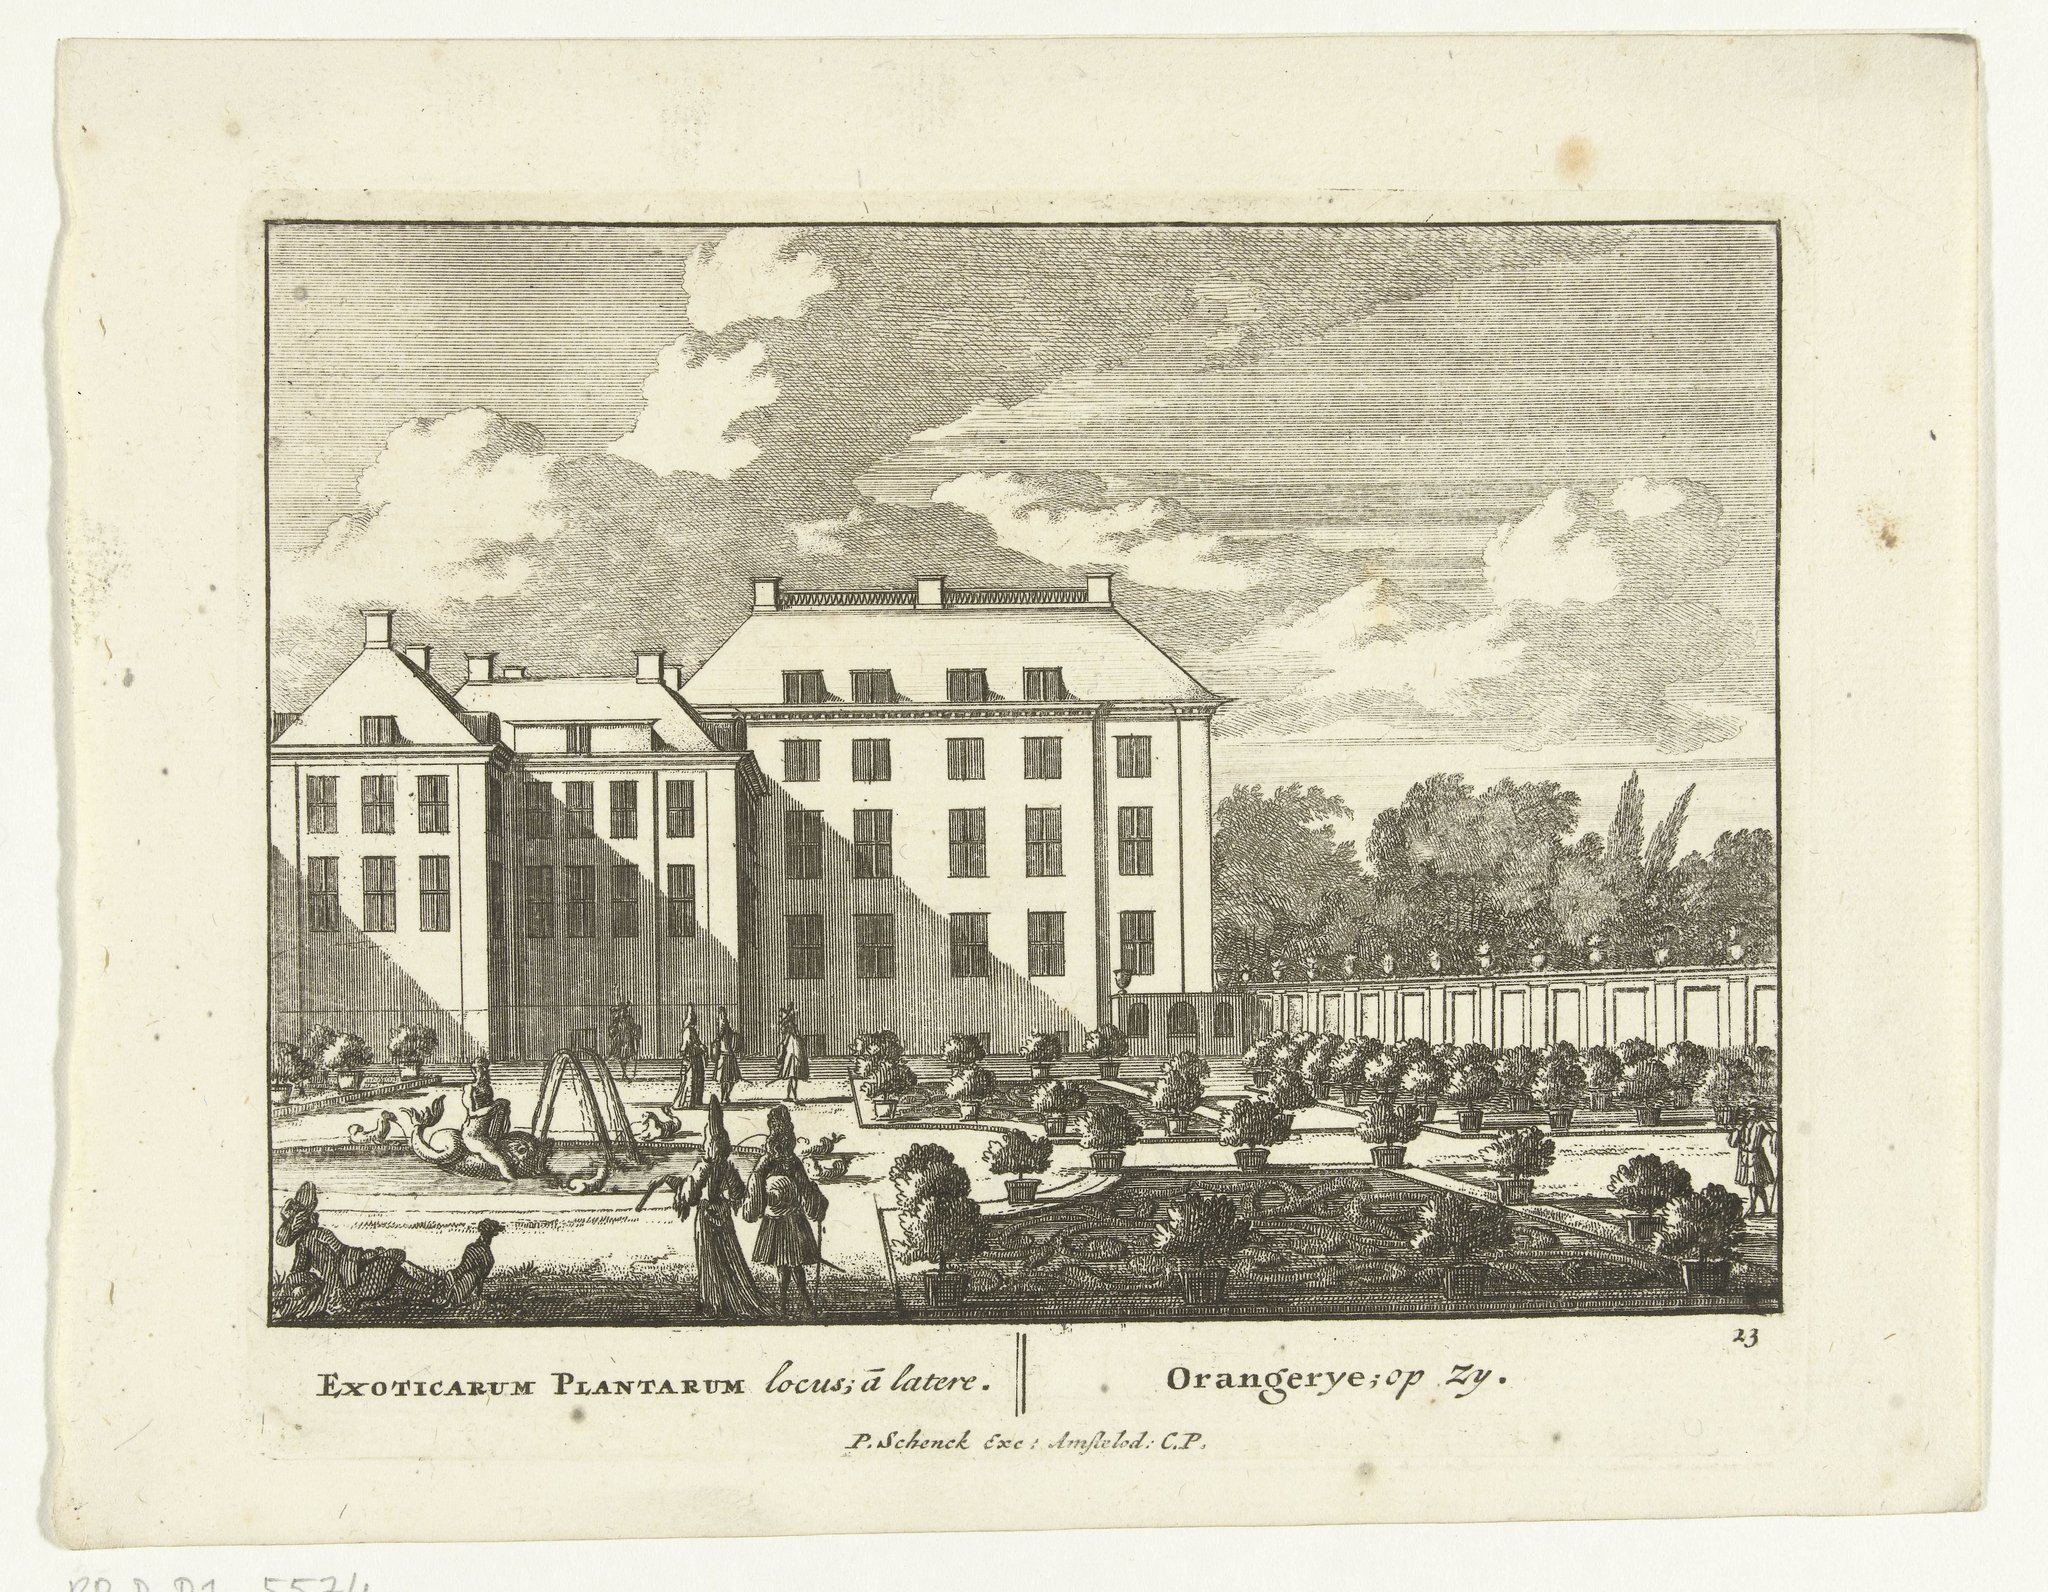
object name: print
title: Uitgeleesene Gesichte van het Wijdvermaarde Loo als andere vorstelijke Huisen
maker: pieter schenk (i)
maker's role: print maker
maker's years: 1660-1711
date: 1695-1705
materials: paper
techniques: etching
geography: amsterdam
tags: palace, french or architectonic garden; formal garden, greenhouse, orangery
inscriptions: collector's mark: Lugt 2228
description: Gezicht op de zijkant van de orangerie van Het Loo vanuit de tuin, waarin elegant geklede dames en heren langs een fontein en langs de parterres flaneren. Prent uit een serie van 71 prenten met Rijnlandschappen, gezichten op vorstelijke paleizen en stadsgezichten uit Den Haag en Amsterdam.